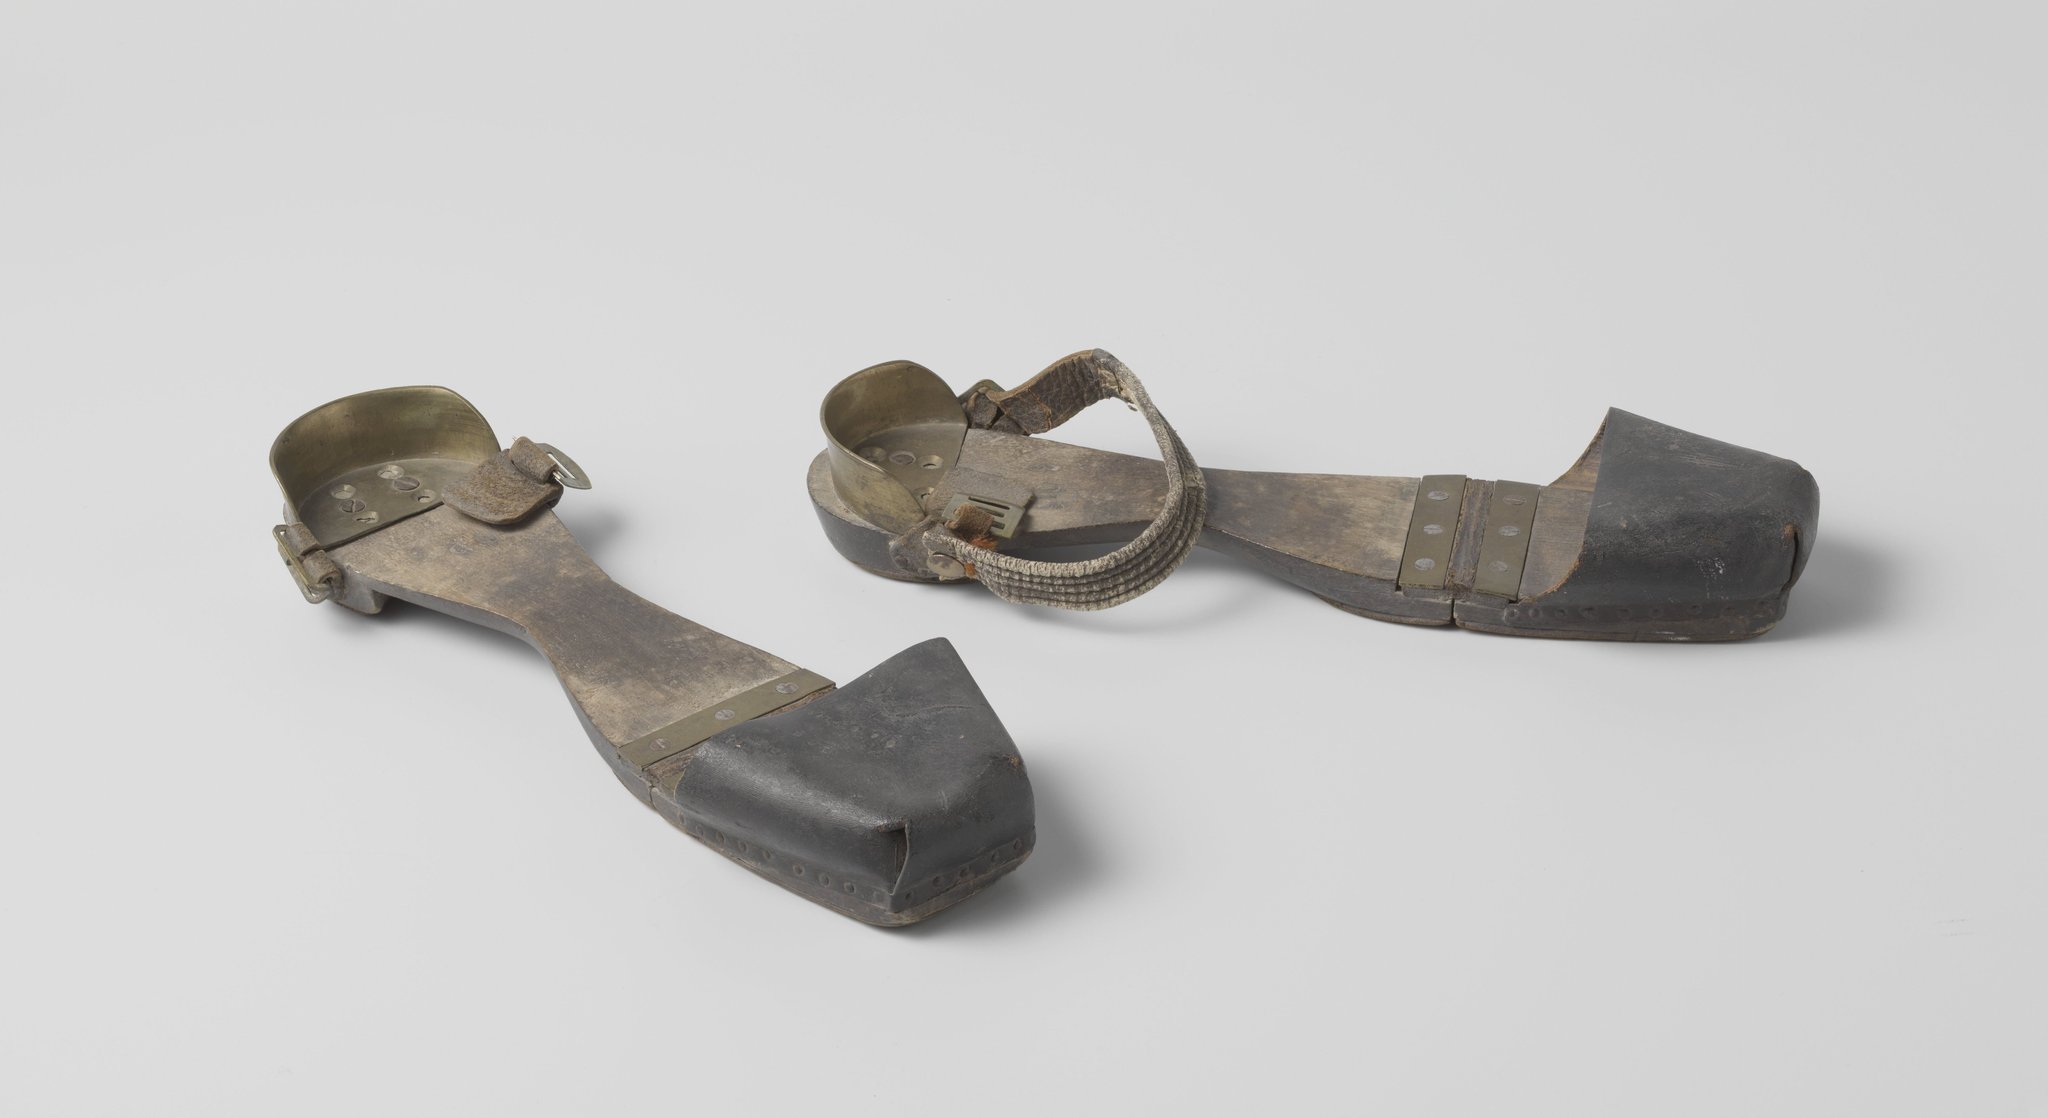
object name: mule shoe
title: Schoen of muil met zolen van hout die in de buiging van de voet scharnieren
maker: Anonymous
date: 1800-1900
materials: copper, leather, wood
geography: netherlands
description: Schoen of muil met zolen van hout die in de buiging van de voet scharnieren. Voorzool en hak van leer, vierkante neus. Hielband en gespen van koper.